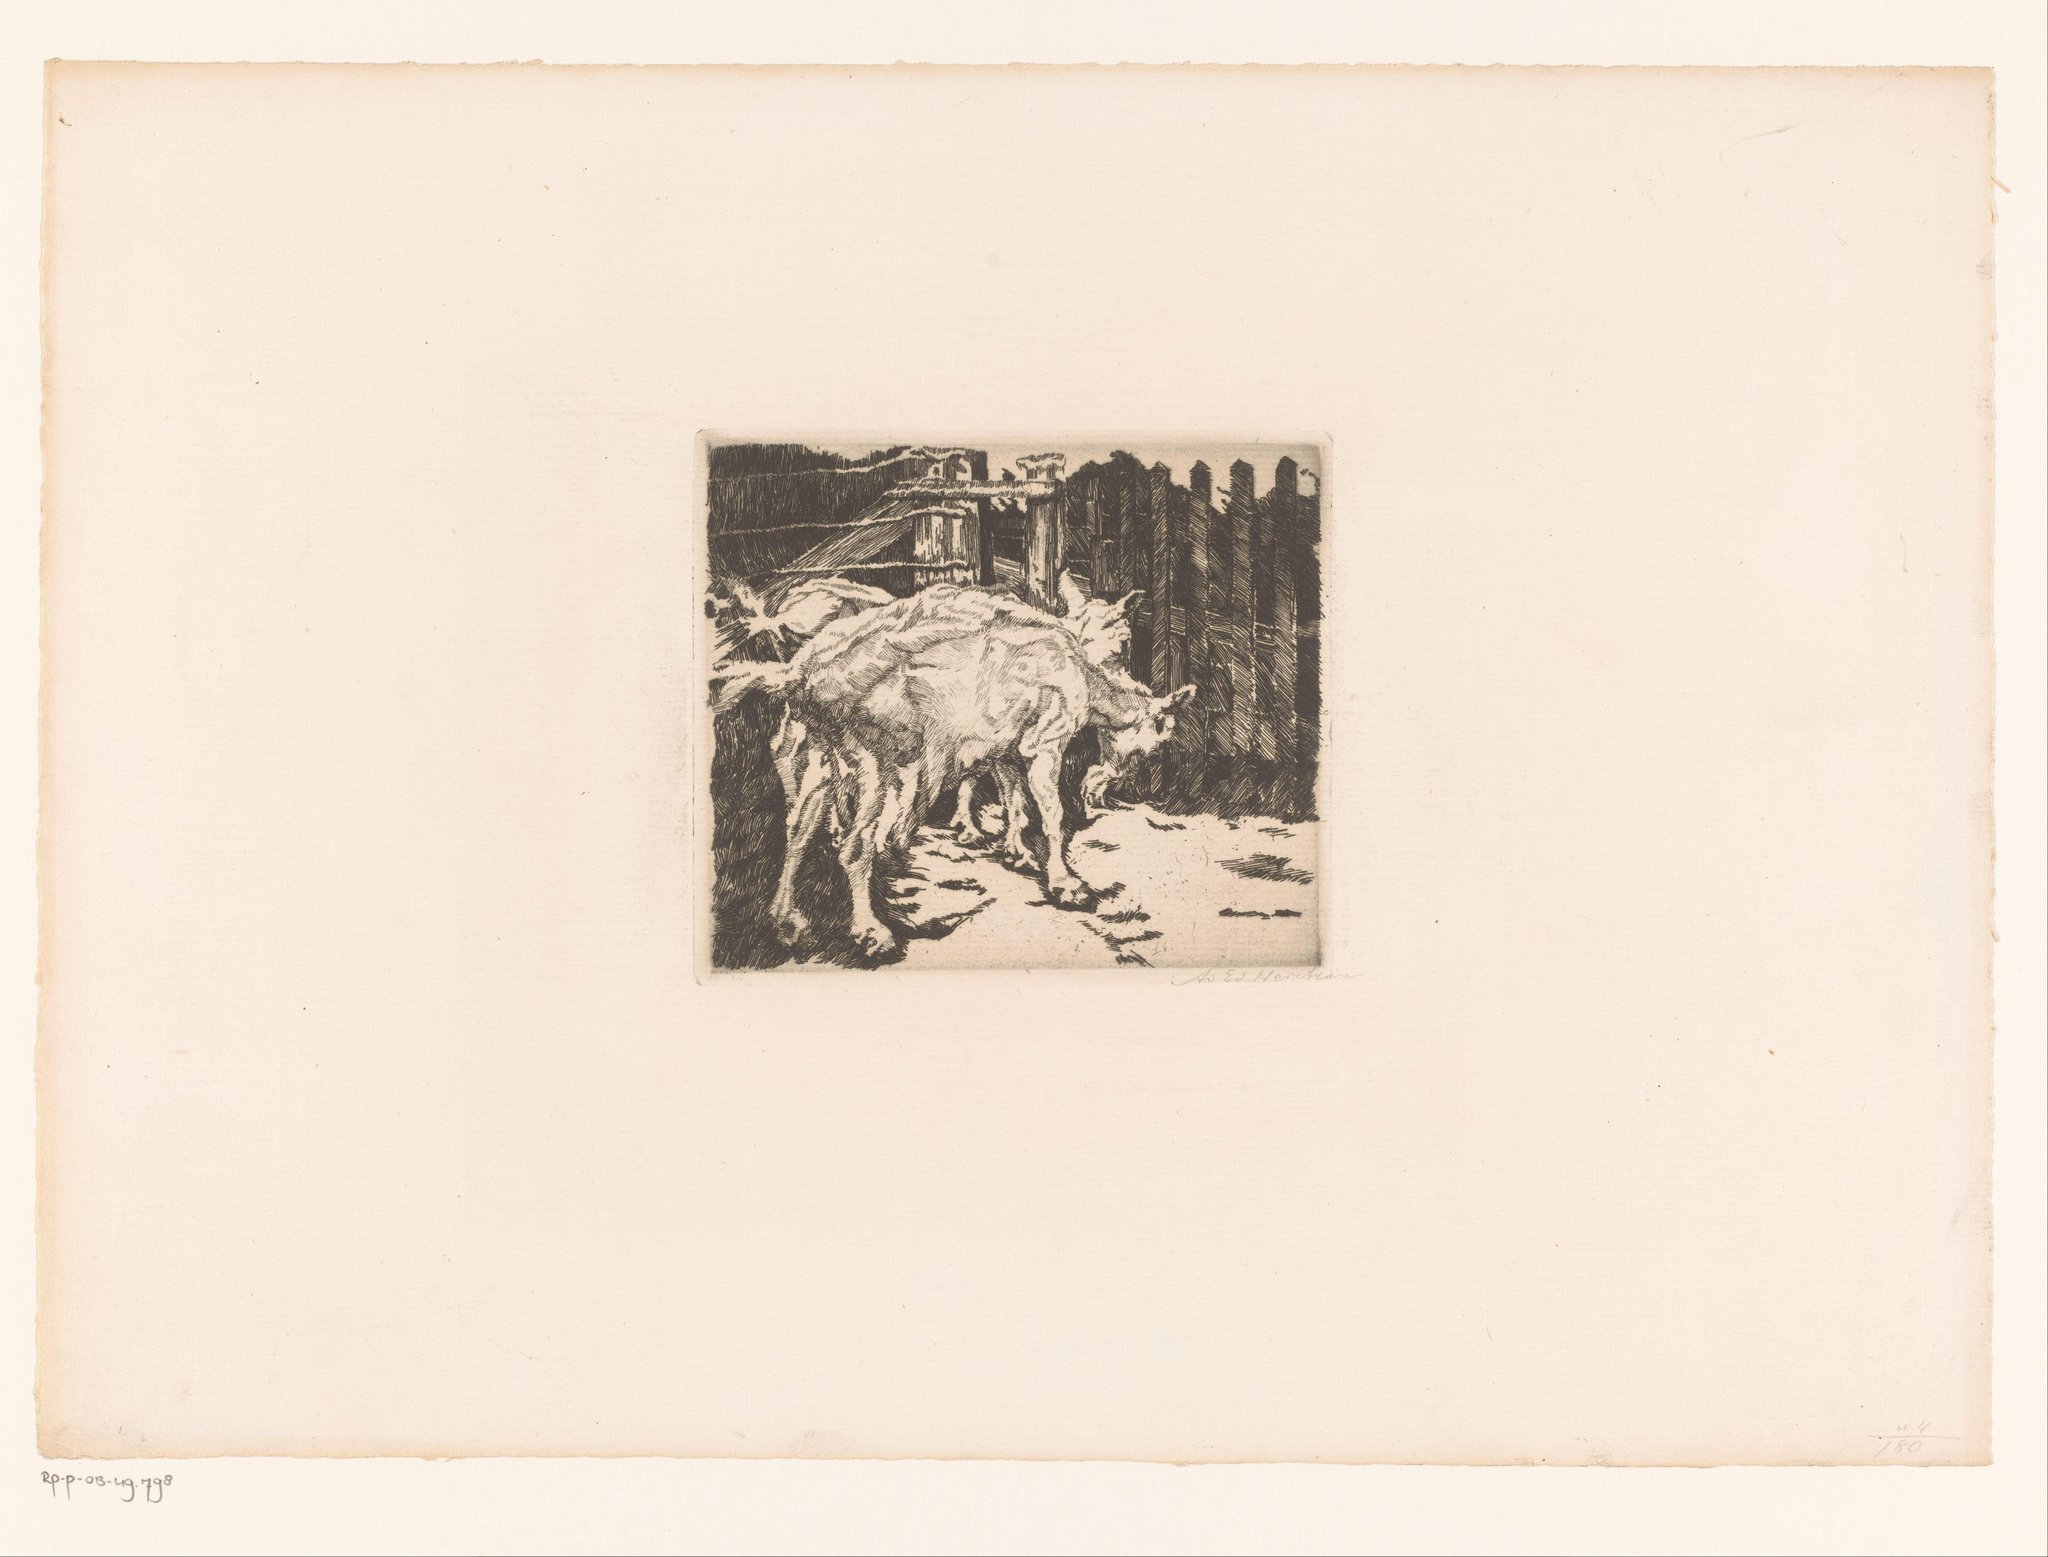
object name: print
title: Geiten bij een hek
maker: adolf eduard herstein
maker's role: print maker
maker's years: 1869-1932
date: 1879-1932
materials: paper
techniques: drypoint, etching, intaglio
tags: goat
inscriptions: collector's mark: Lugt 2228